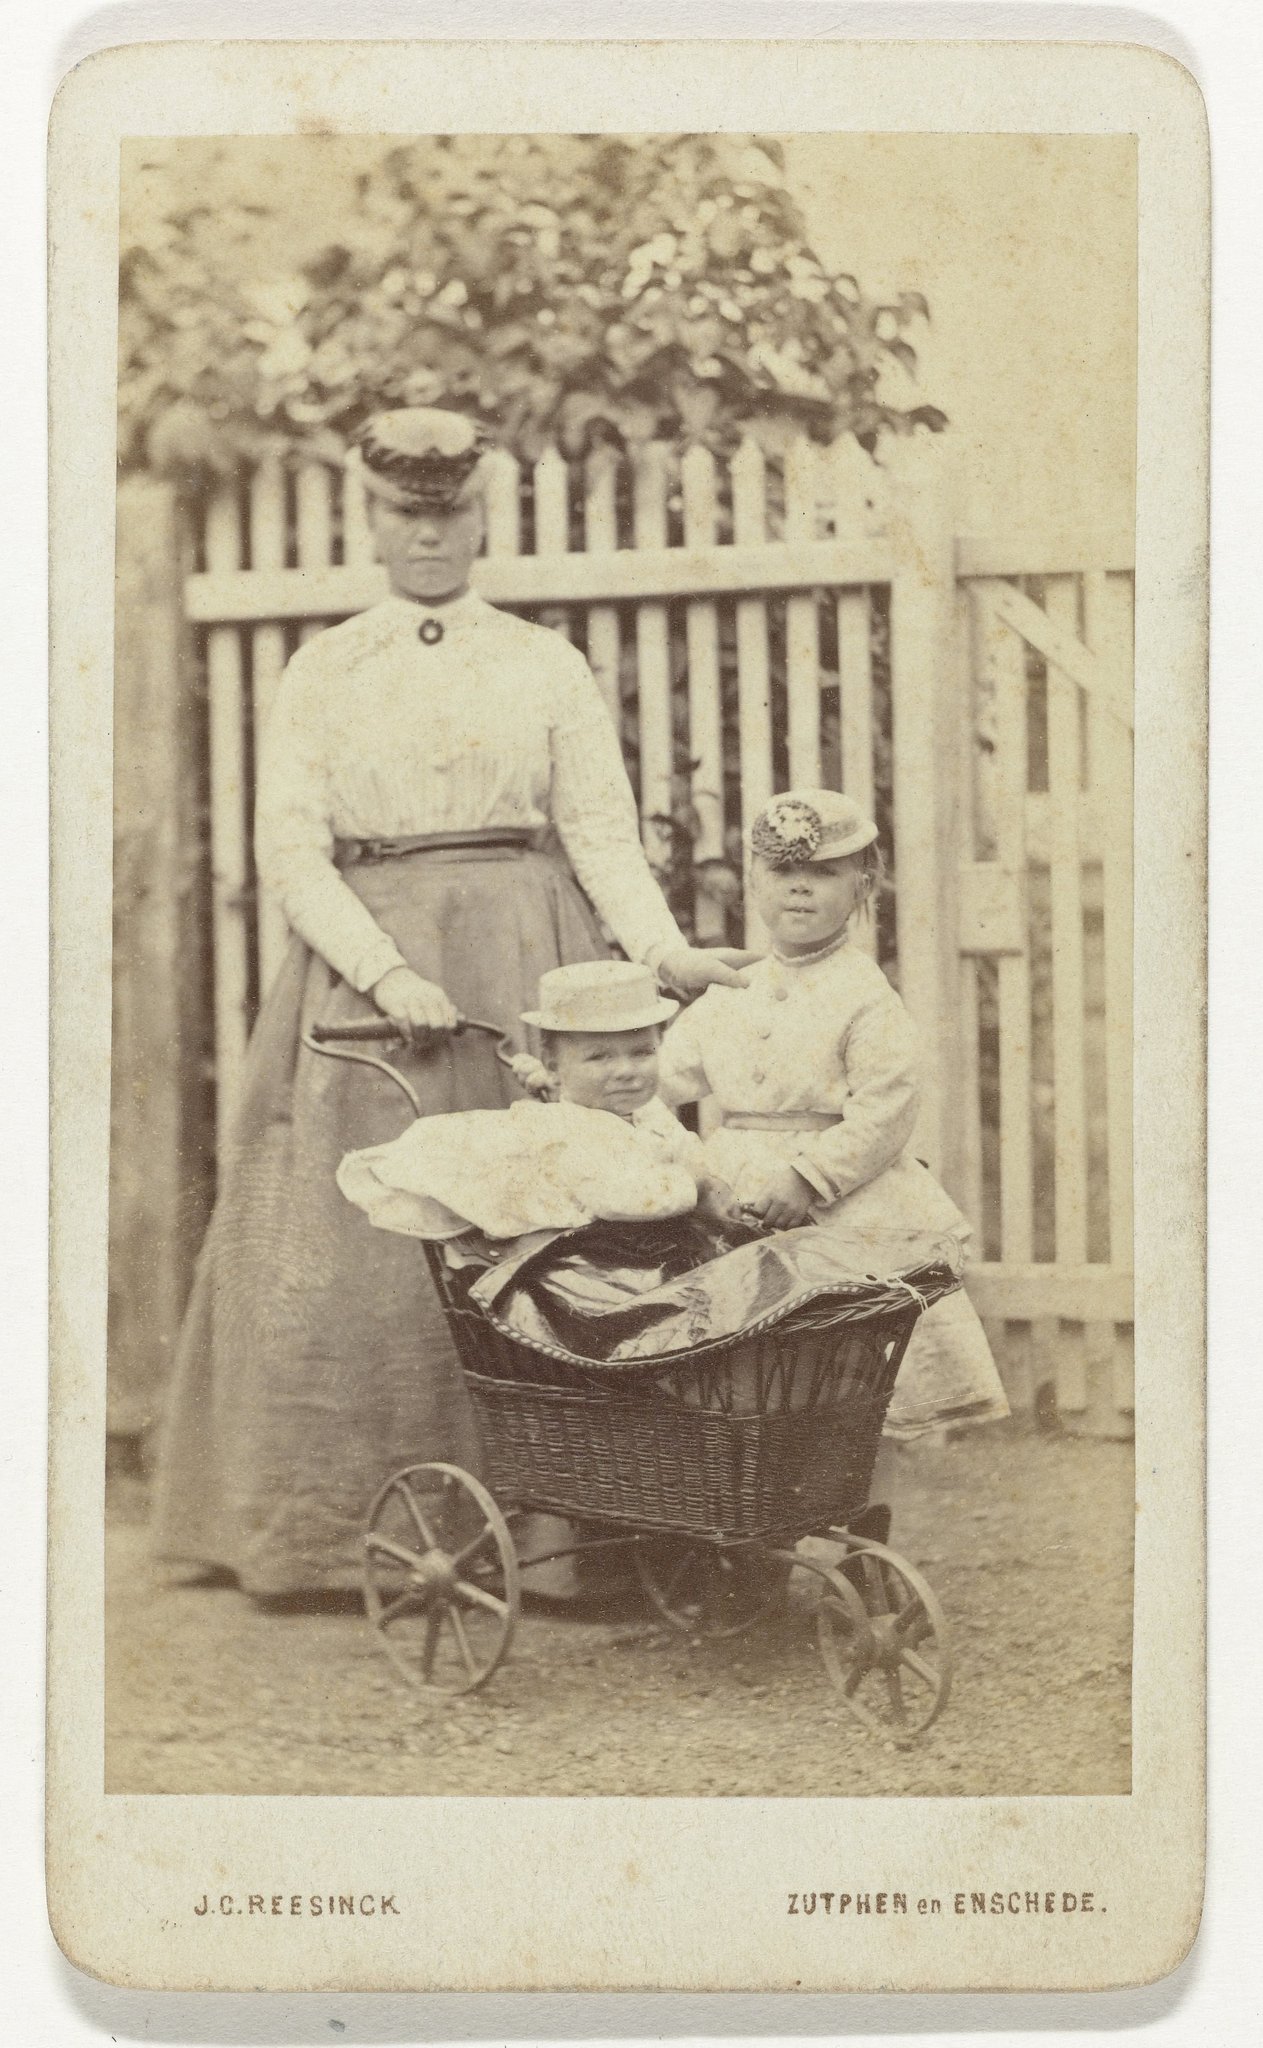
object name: photograph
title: Portret van een vrouw met twee kinderen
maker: johan christiaan reesinck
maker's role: fotograaf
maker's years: 1838-1922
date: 1867-1870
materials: cardboard, paper, photographic support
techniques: albumen print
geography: zutphen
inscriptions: address: ‘J.C. Reesinck/Photograaf/Zutphen/en/Enschede’, annotation: ‘J:4j W:1j’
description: Staande vrouw bij kinderwagen met baby erin en kleuter ernaast. Alle drie een hoedje op. Buiten bij een houten hek.